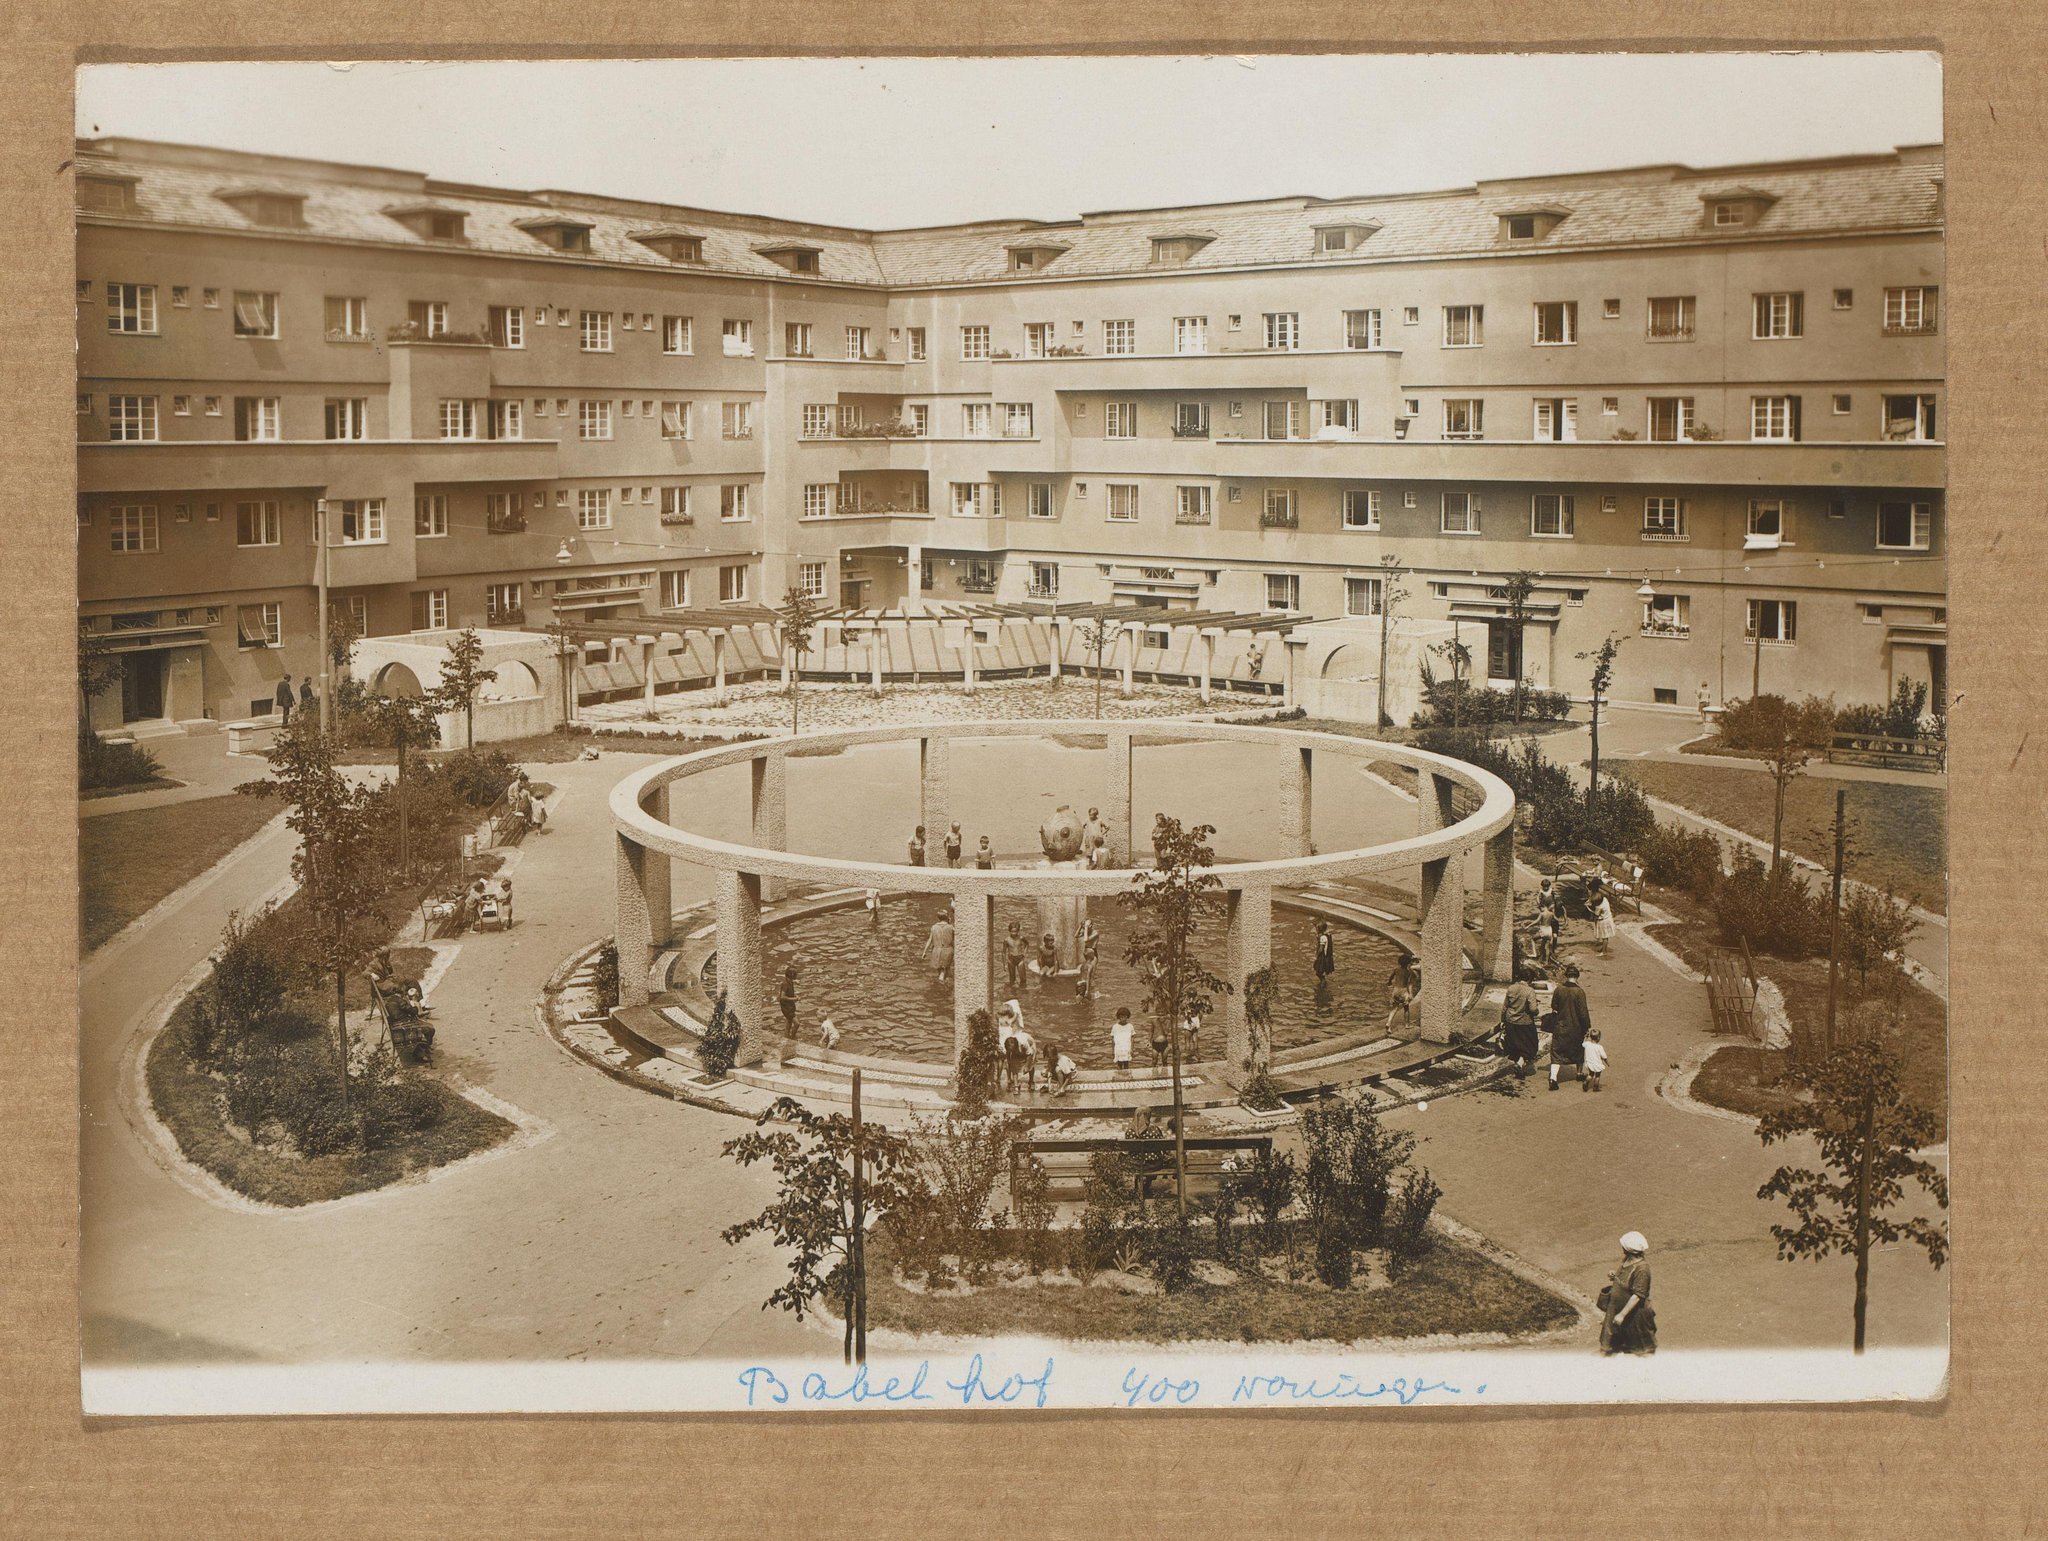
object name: photograph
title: Wenen. Babelhof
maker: Anonymous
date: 1880-1920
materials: photographic support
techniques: gelatin silver print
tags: vienna